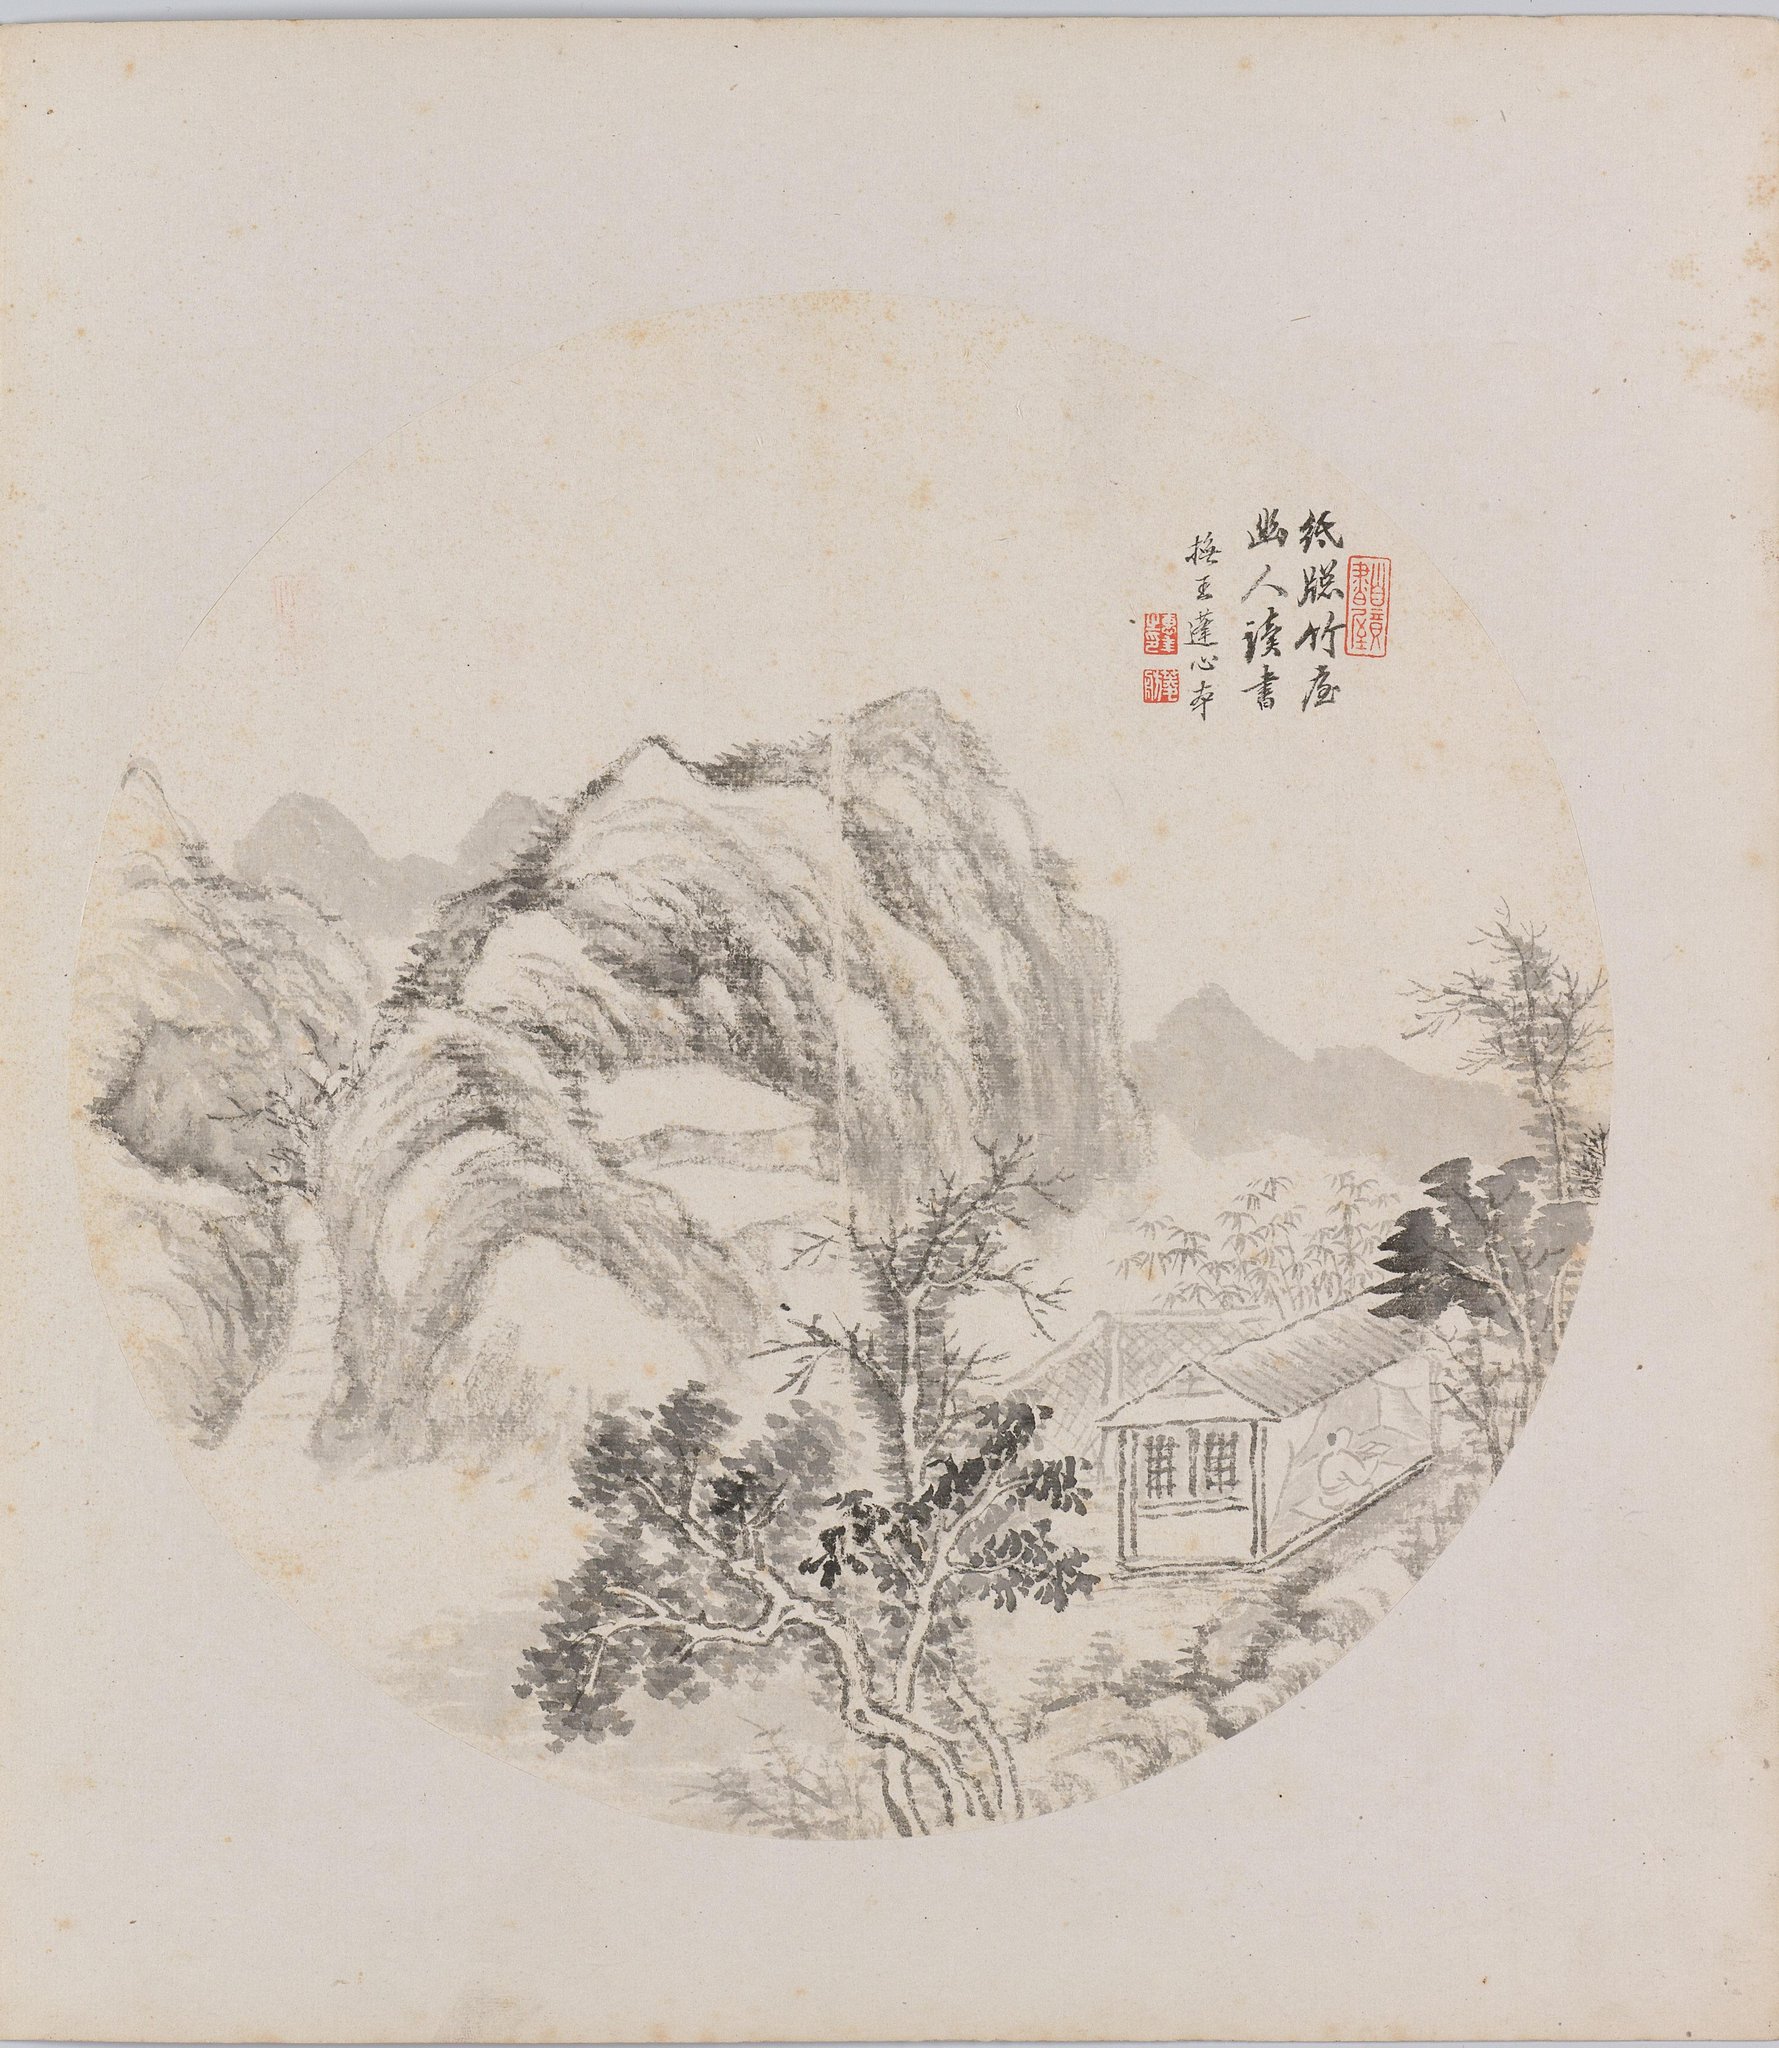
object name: album leaf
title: Albumblad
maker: hui nian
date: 1850-1900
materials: ink, paper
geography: china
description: Albumblad met een landschap. Behoort twee albums met 24 landschappen in de stijl van diverse meesters.